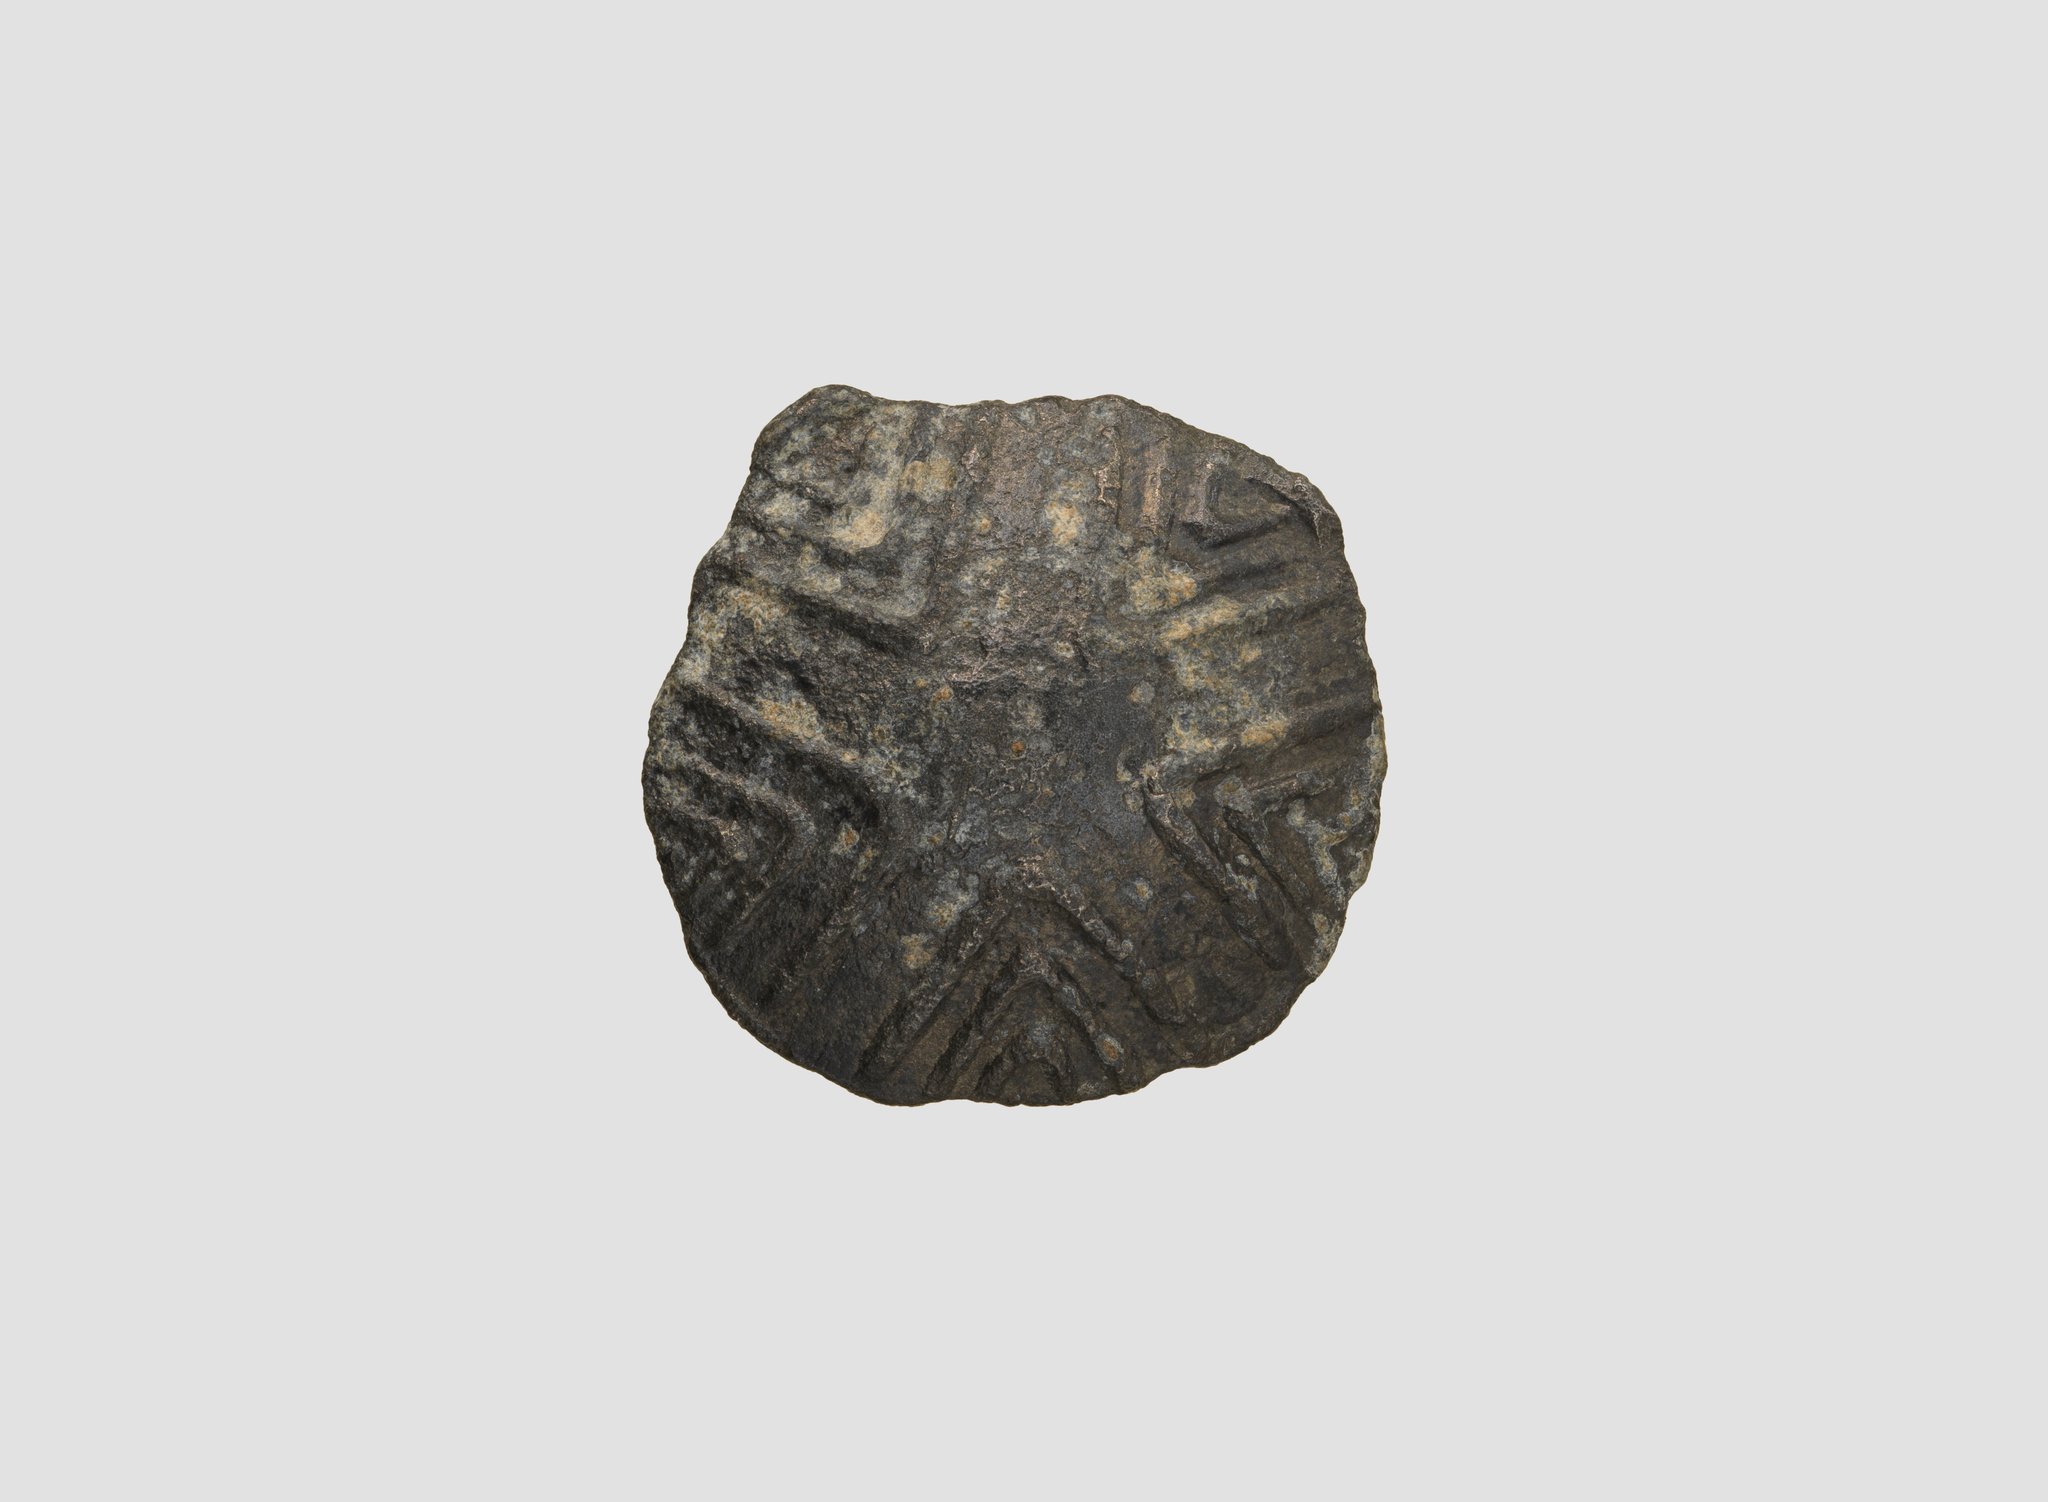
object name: button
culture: iranian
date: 900-801 BCE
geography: iran